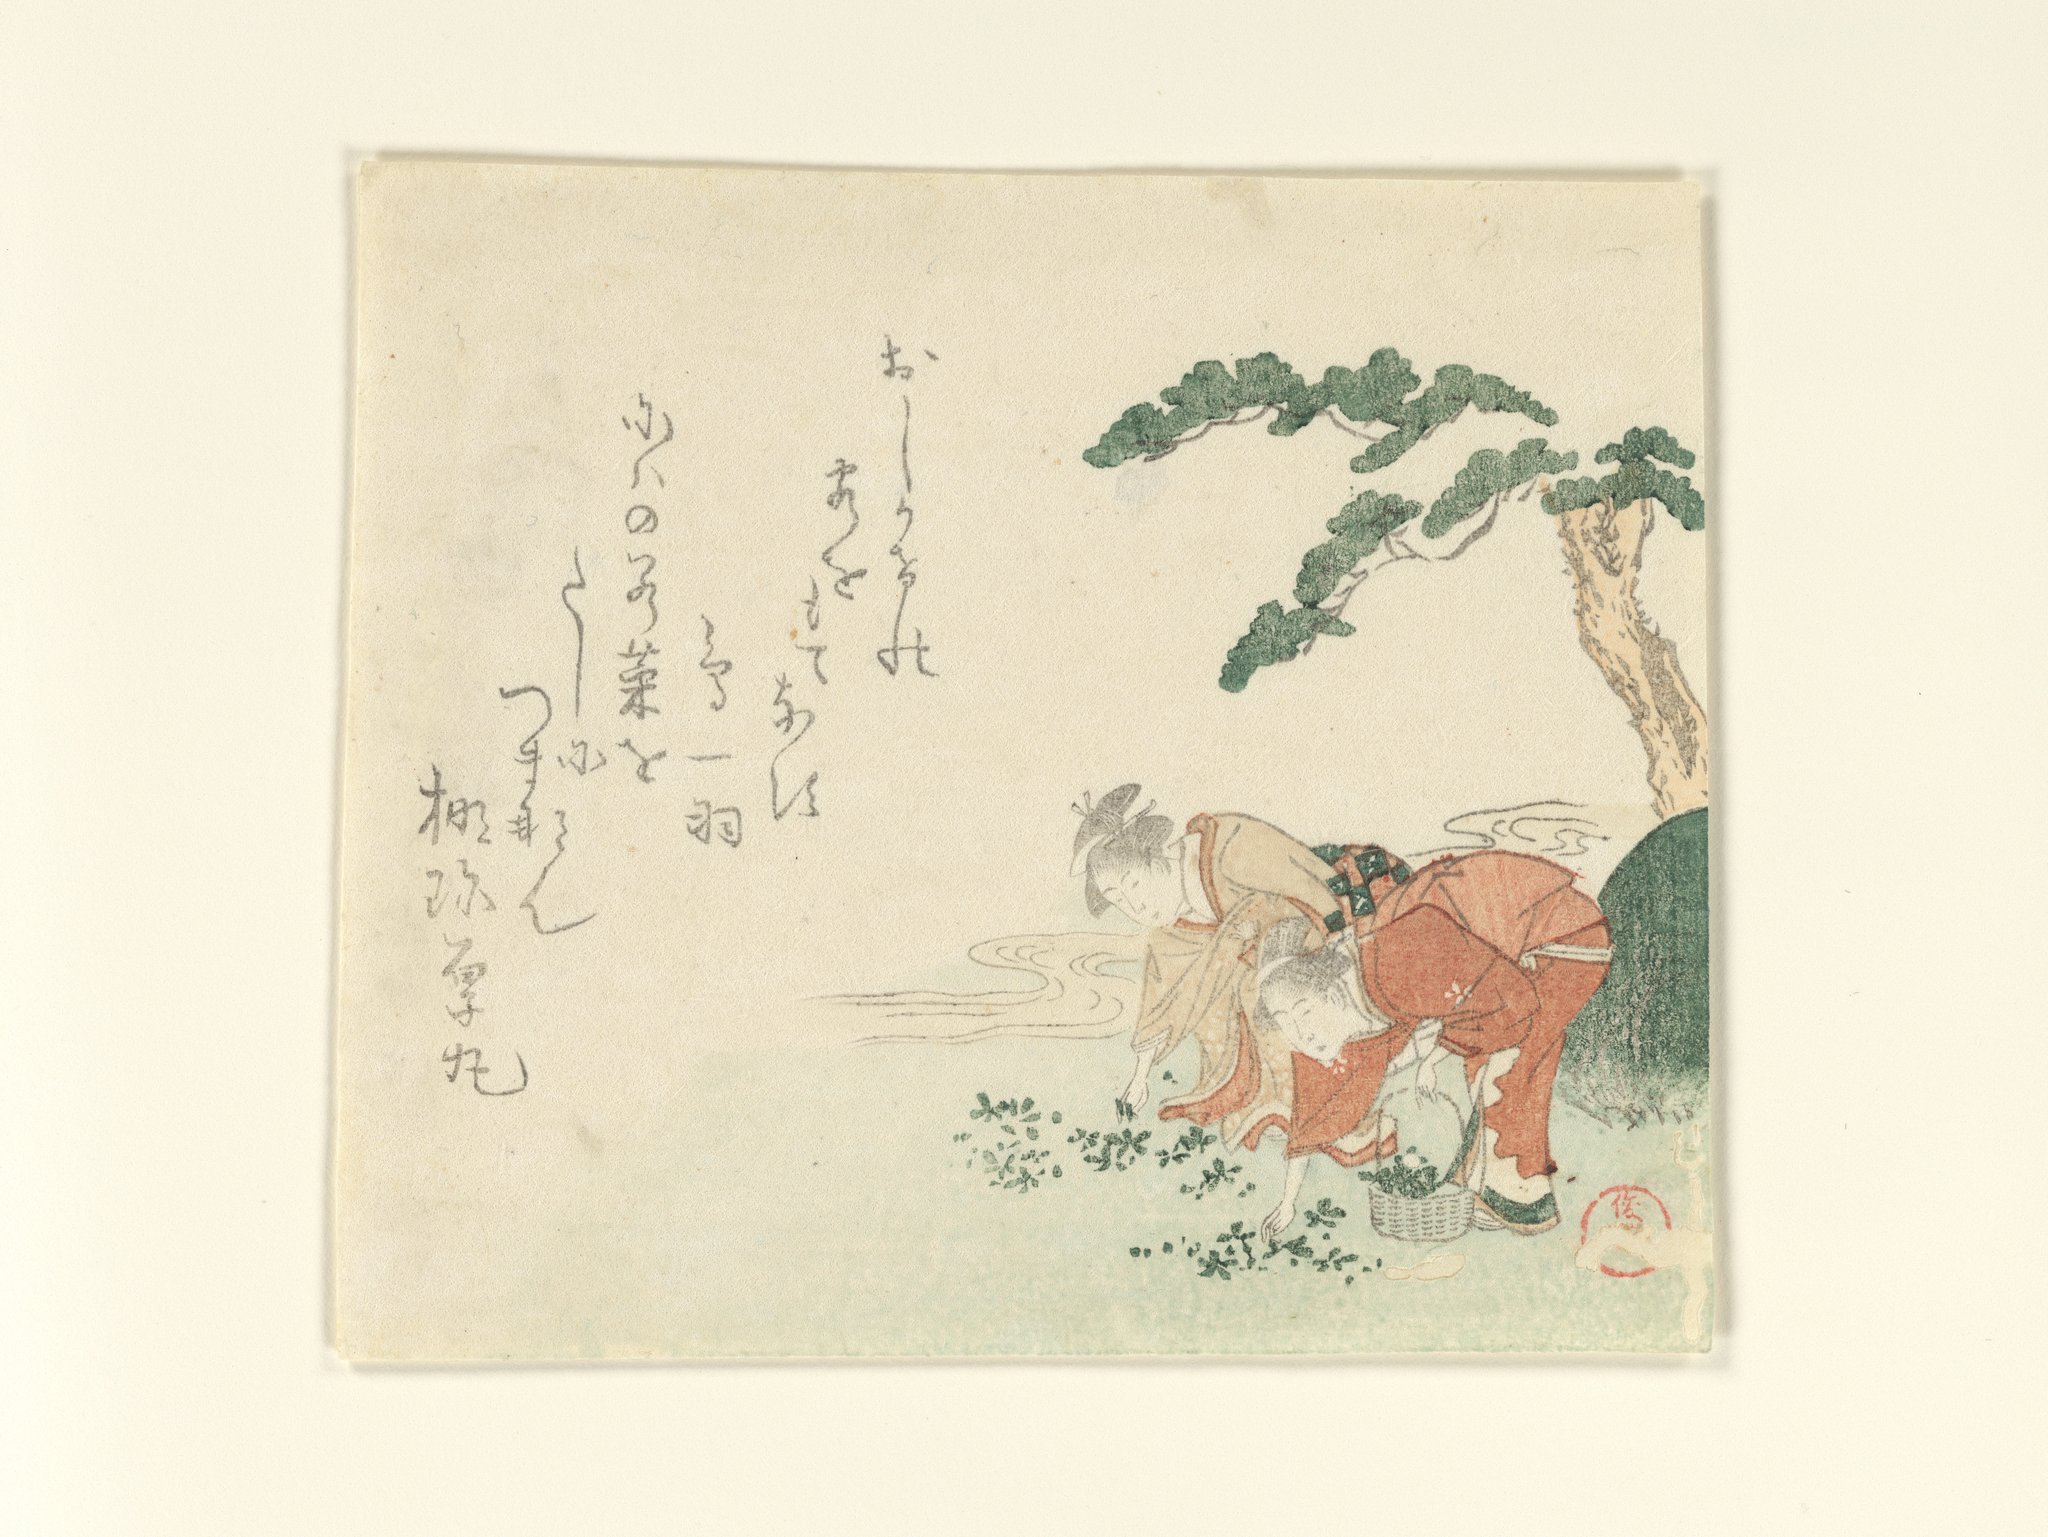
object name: print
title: Two Girls Collect New Year's Herbs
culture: japanese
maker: kubo shunman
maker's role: artist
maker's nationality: japanese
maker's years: 1757-1820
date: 1797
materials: ink, paper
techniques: surimono, woodblock print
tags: girls,herbs,trees